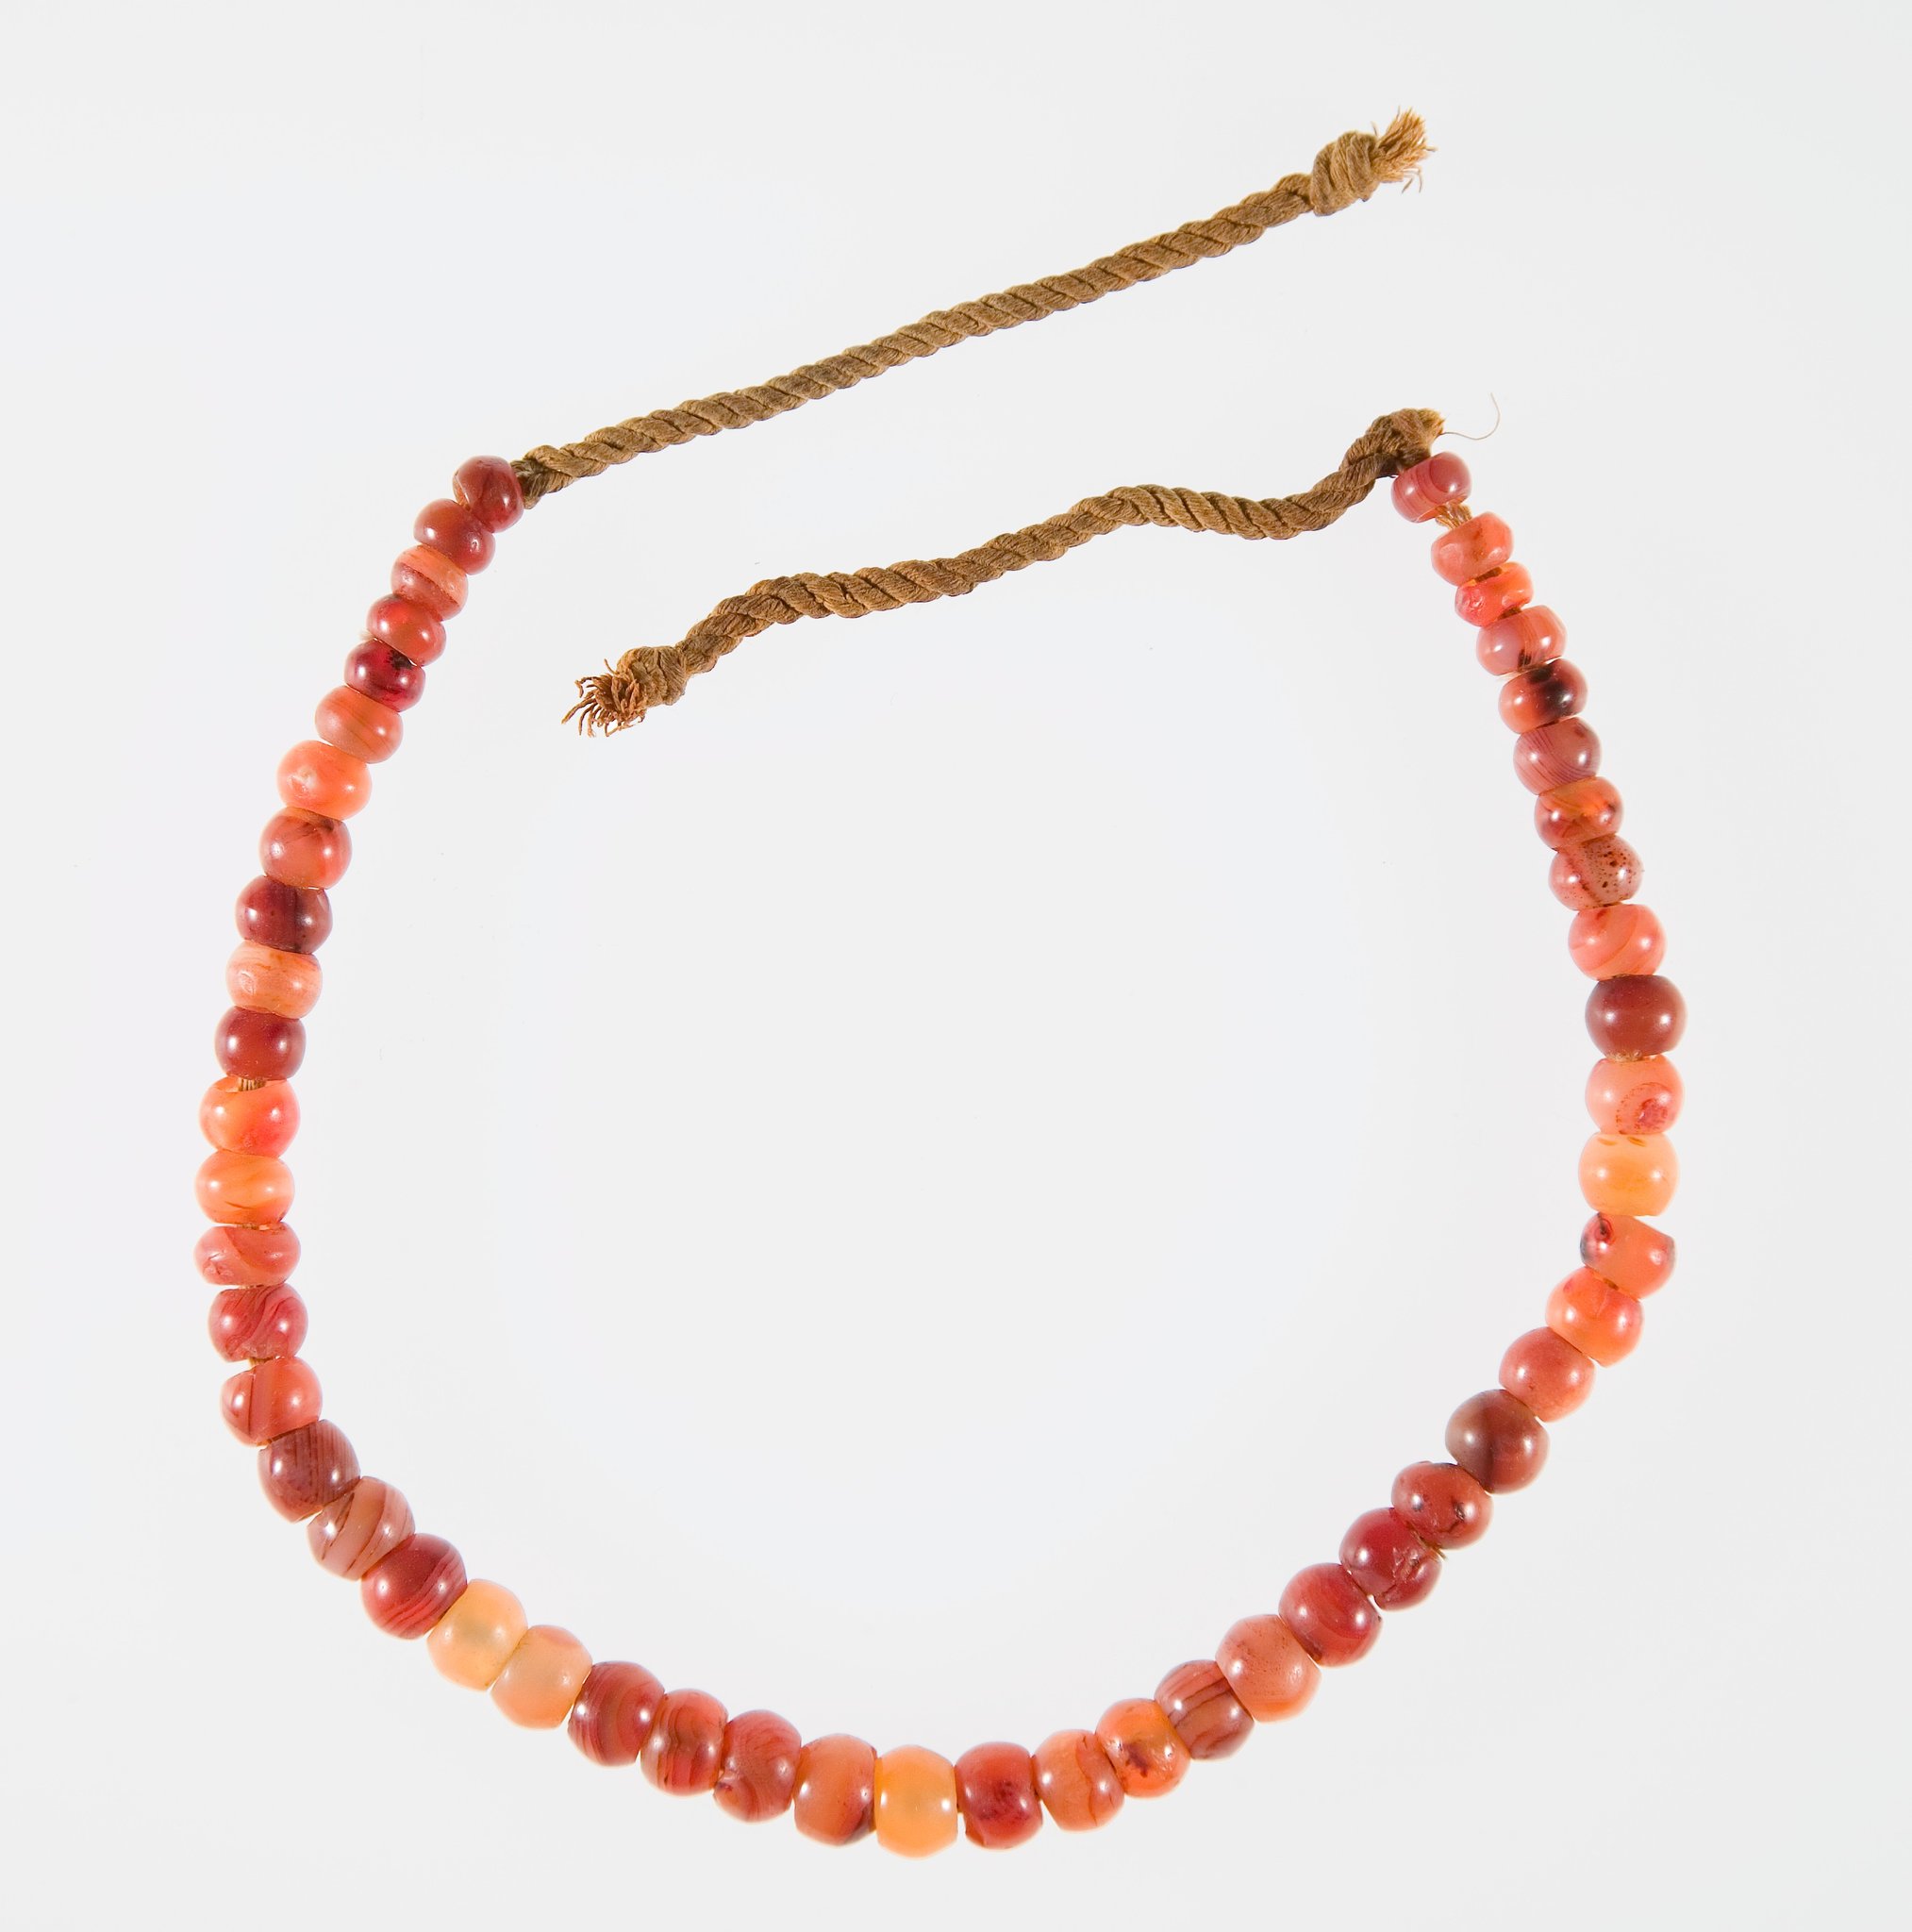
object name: necklace, myt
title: Carnelian Necklace of the Child Myt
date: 2051-2030 BCE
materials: gemstone, cord, linen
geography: egypt